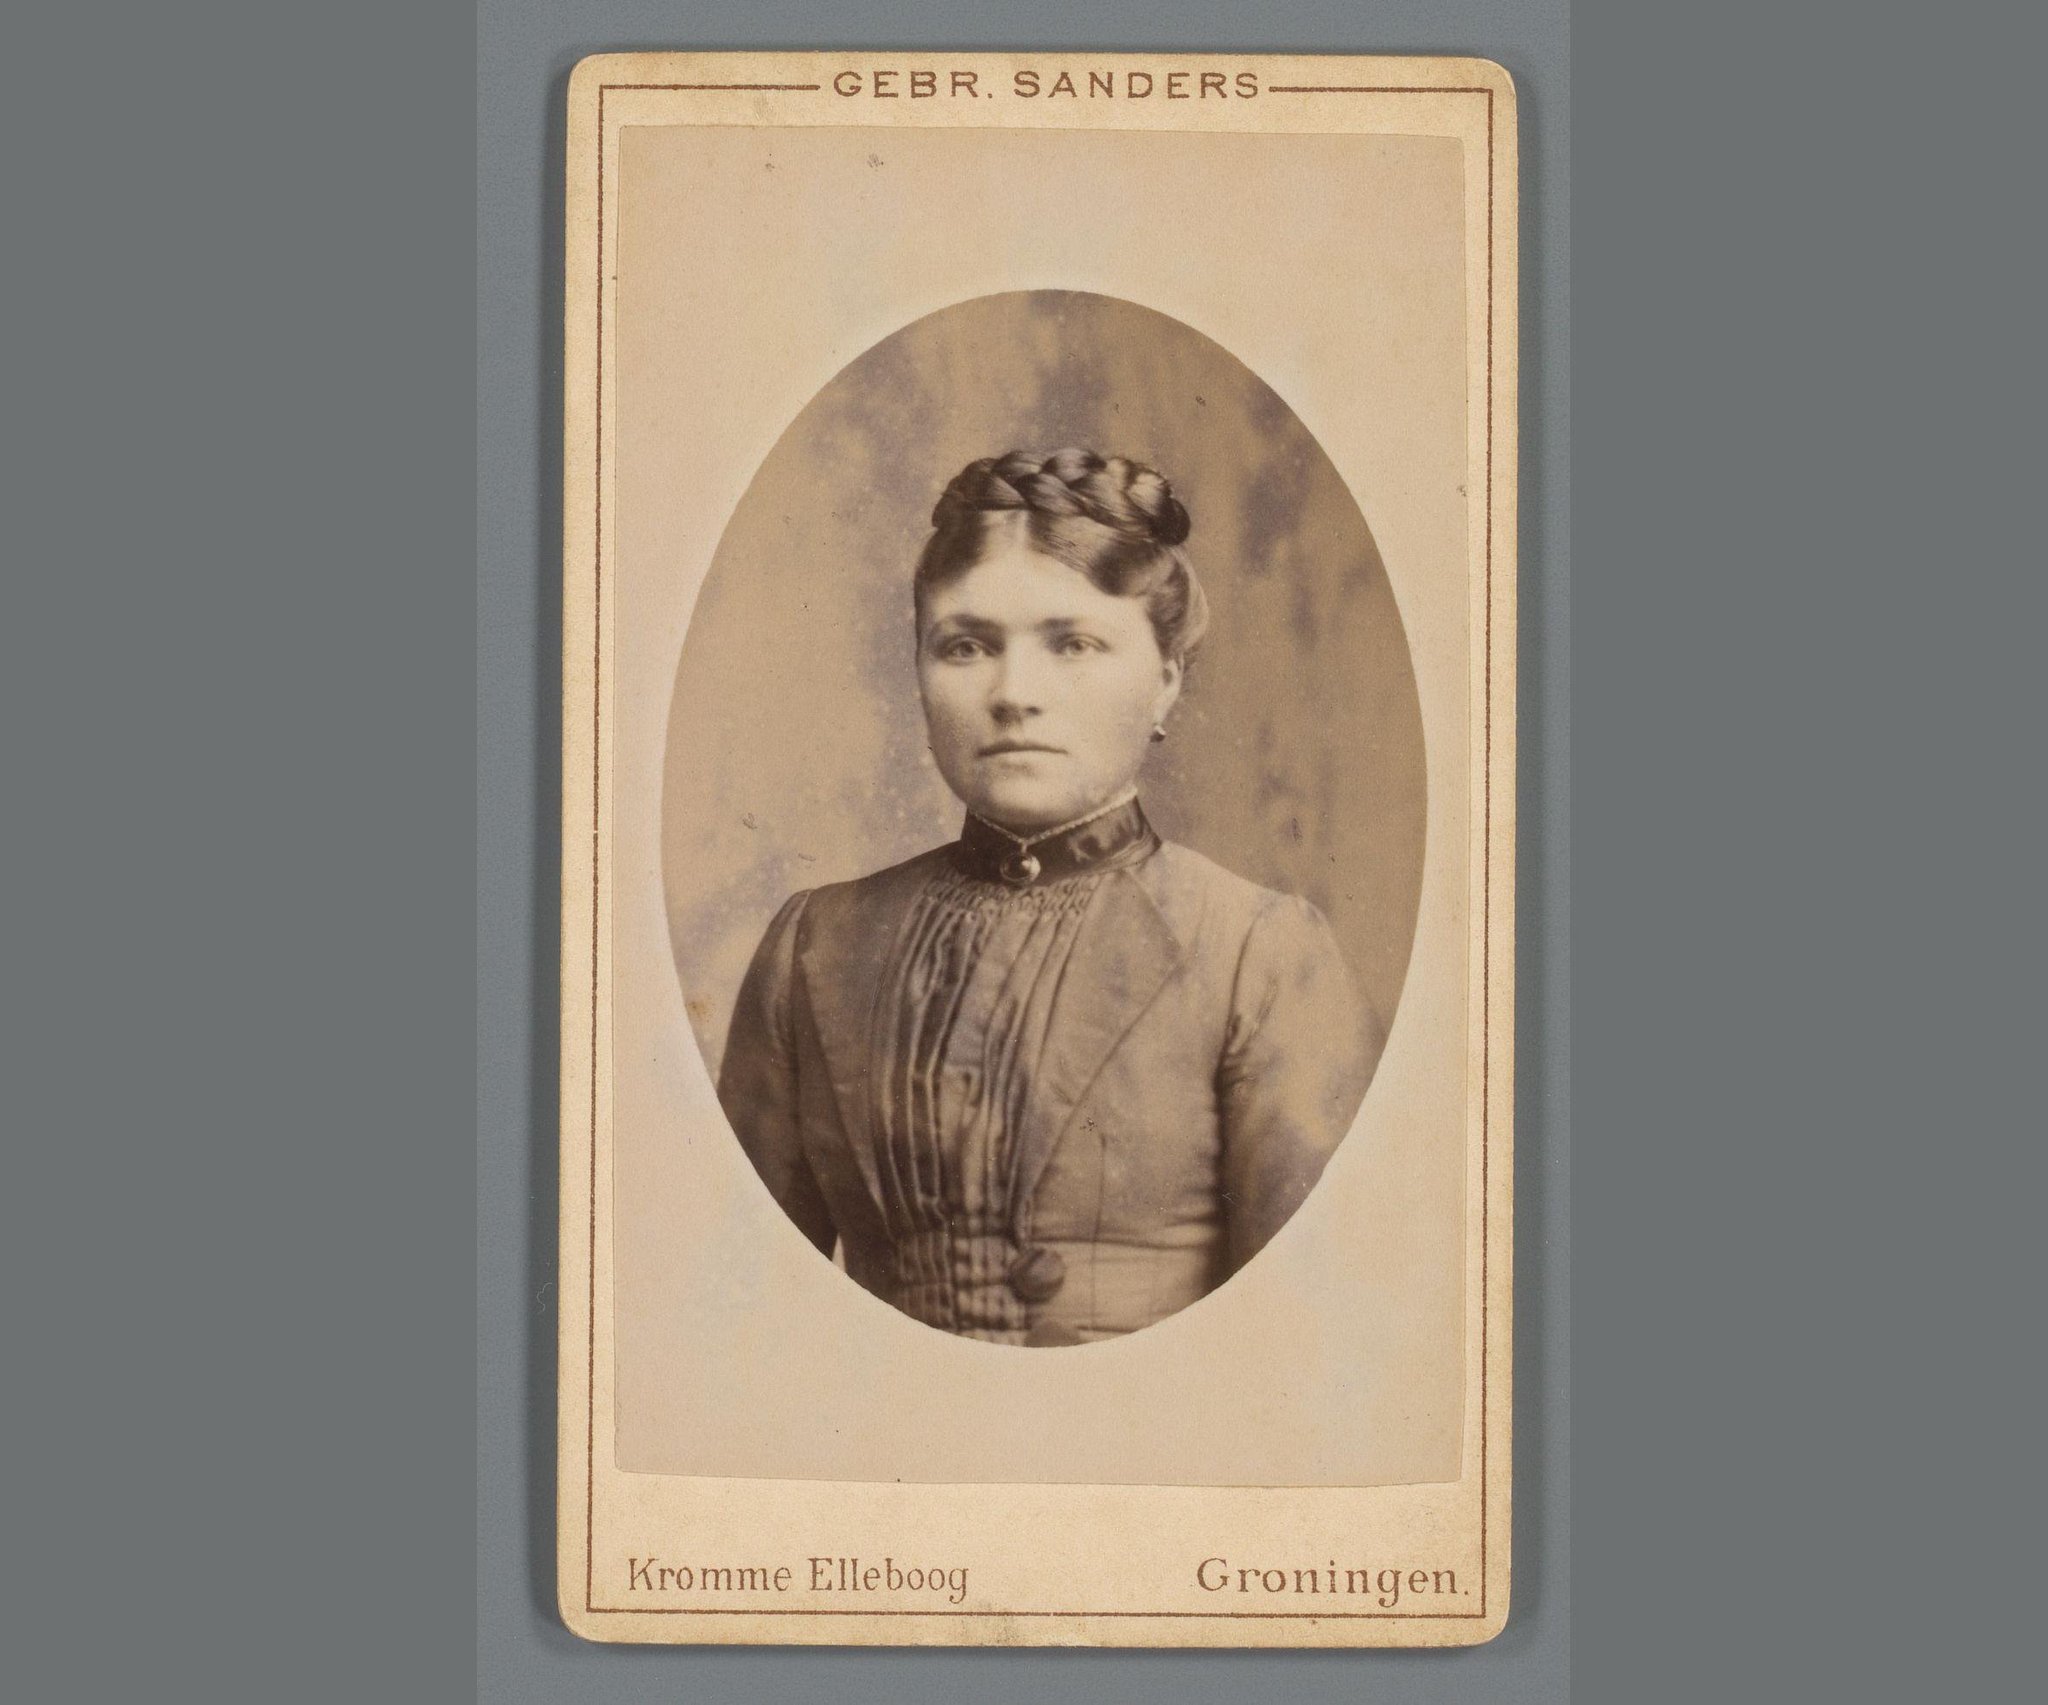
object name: carte de visite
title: Portret van Jacoba Oosting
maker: heiman sanders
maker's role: fotograaf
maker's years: 1839-1922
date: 1880-1896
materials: cardboard, paper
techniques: albumen print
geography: groningen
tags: historical persons - bb - woman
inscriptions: inscription: ‘Jacoba Oosting’, inscription: ‘GS/ Gebr. Sanders/ Photographie Instantanée./ Hoek Stoeldraaierstraat H.13,/ 2de huis Kromme Elleboog/ GRONINGEN/ Specialiteit in vergrootingen, de negativen/ blyven ter nabestelling bewaard.’